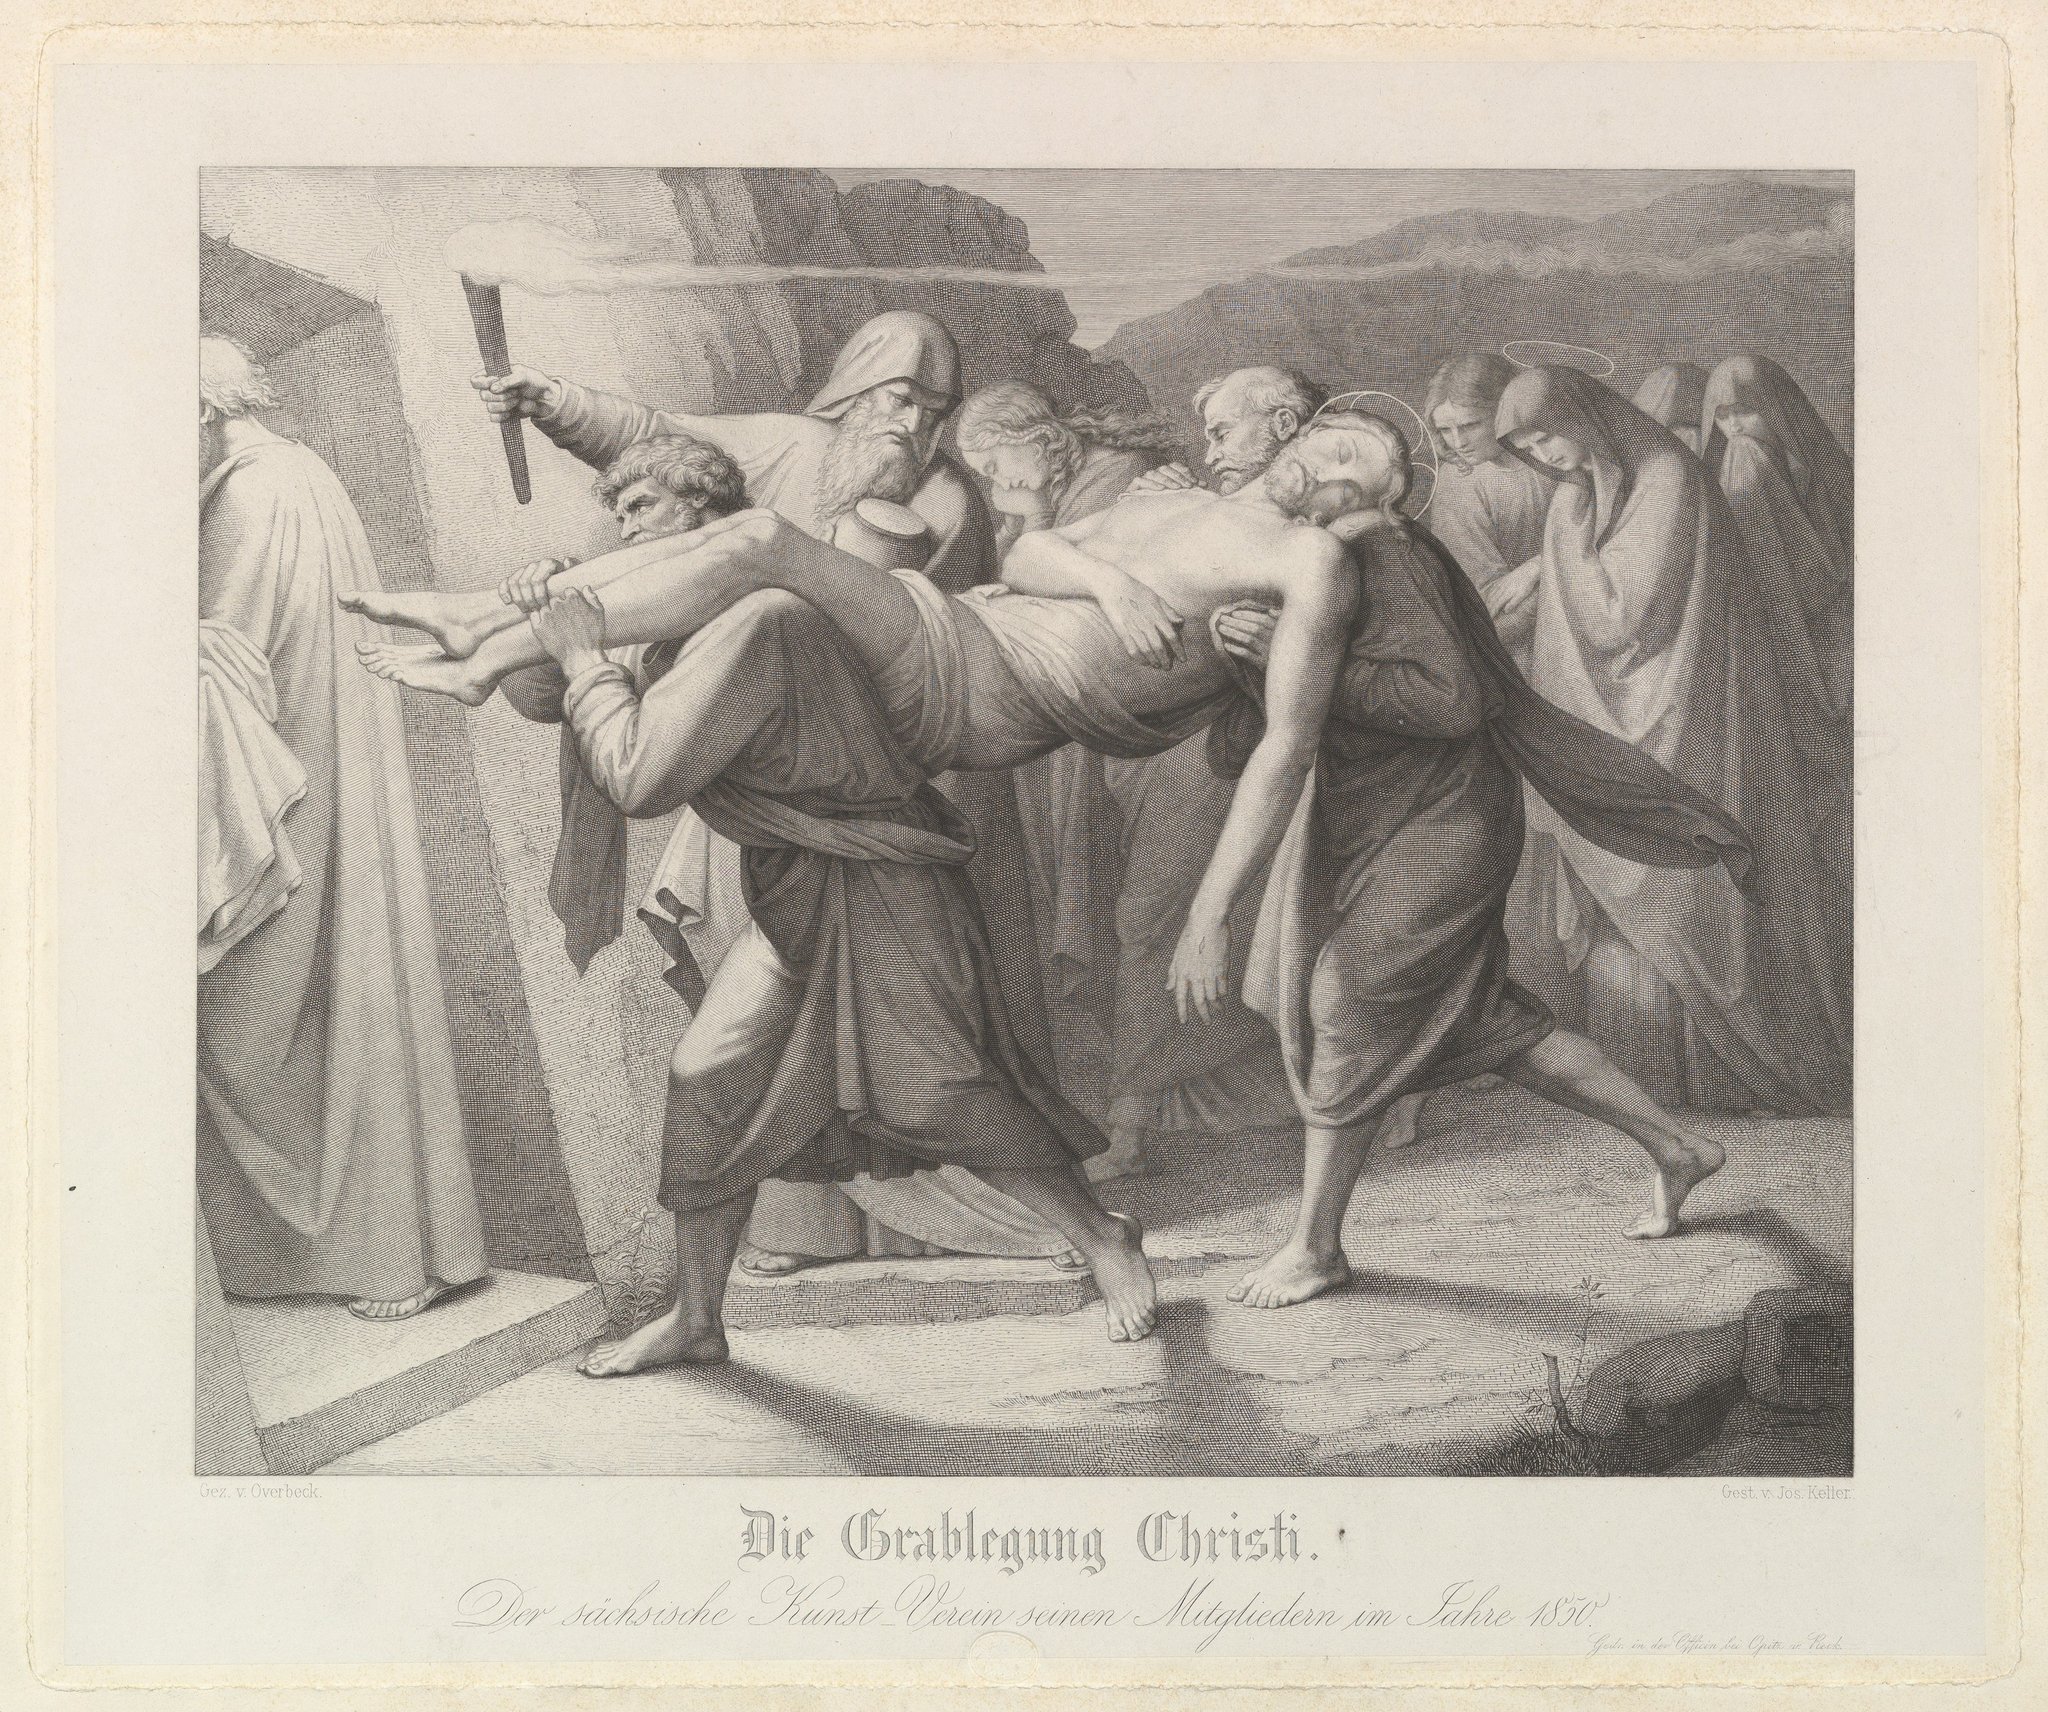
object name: print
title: The Entombment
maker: johann friedrich overbeck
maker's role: artist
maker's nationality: german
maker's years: 1789-1869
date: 1850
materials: steel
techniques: engraving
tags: men,women,christ,entombment